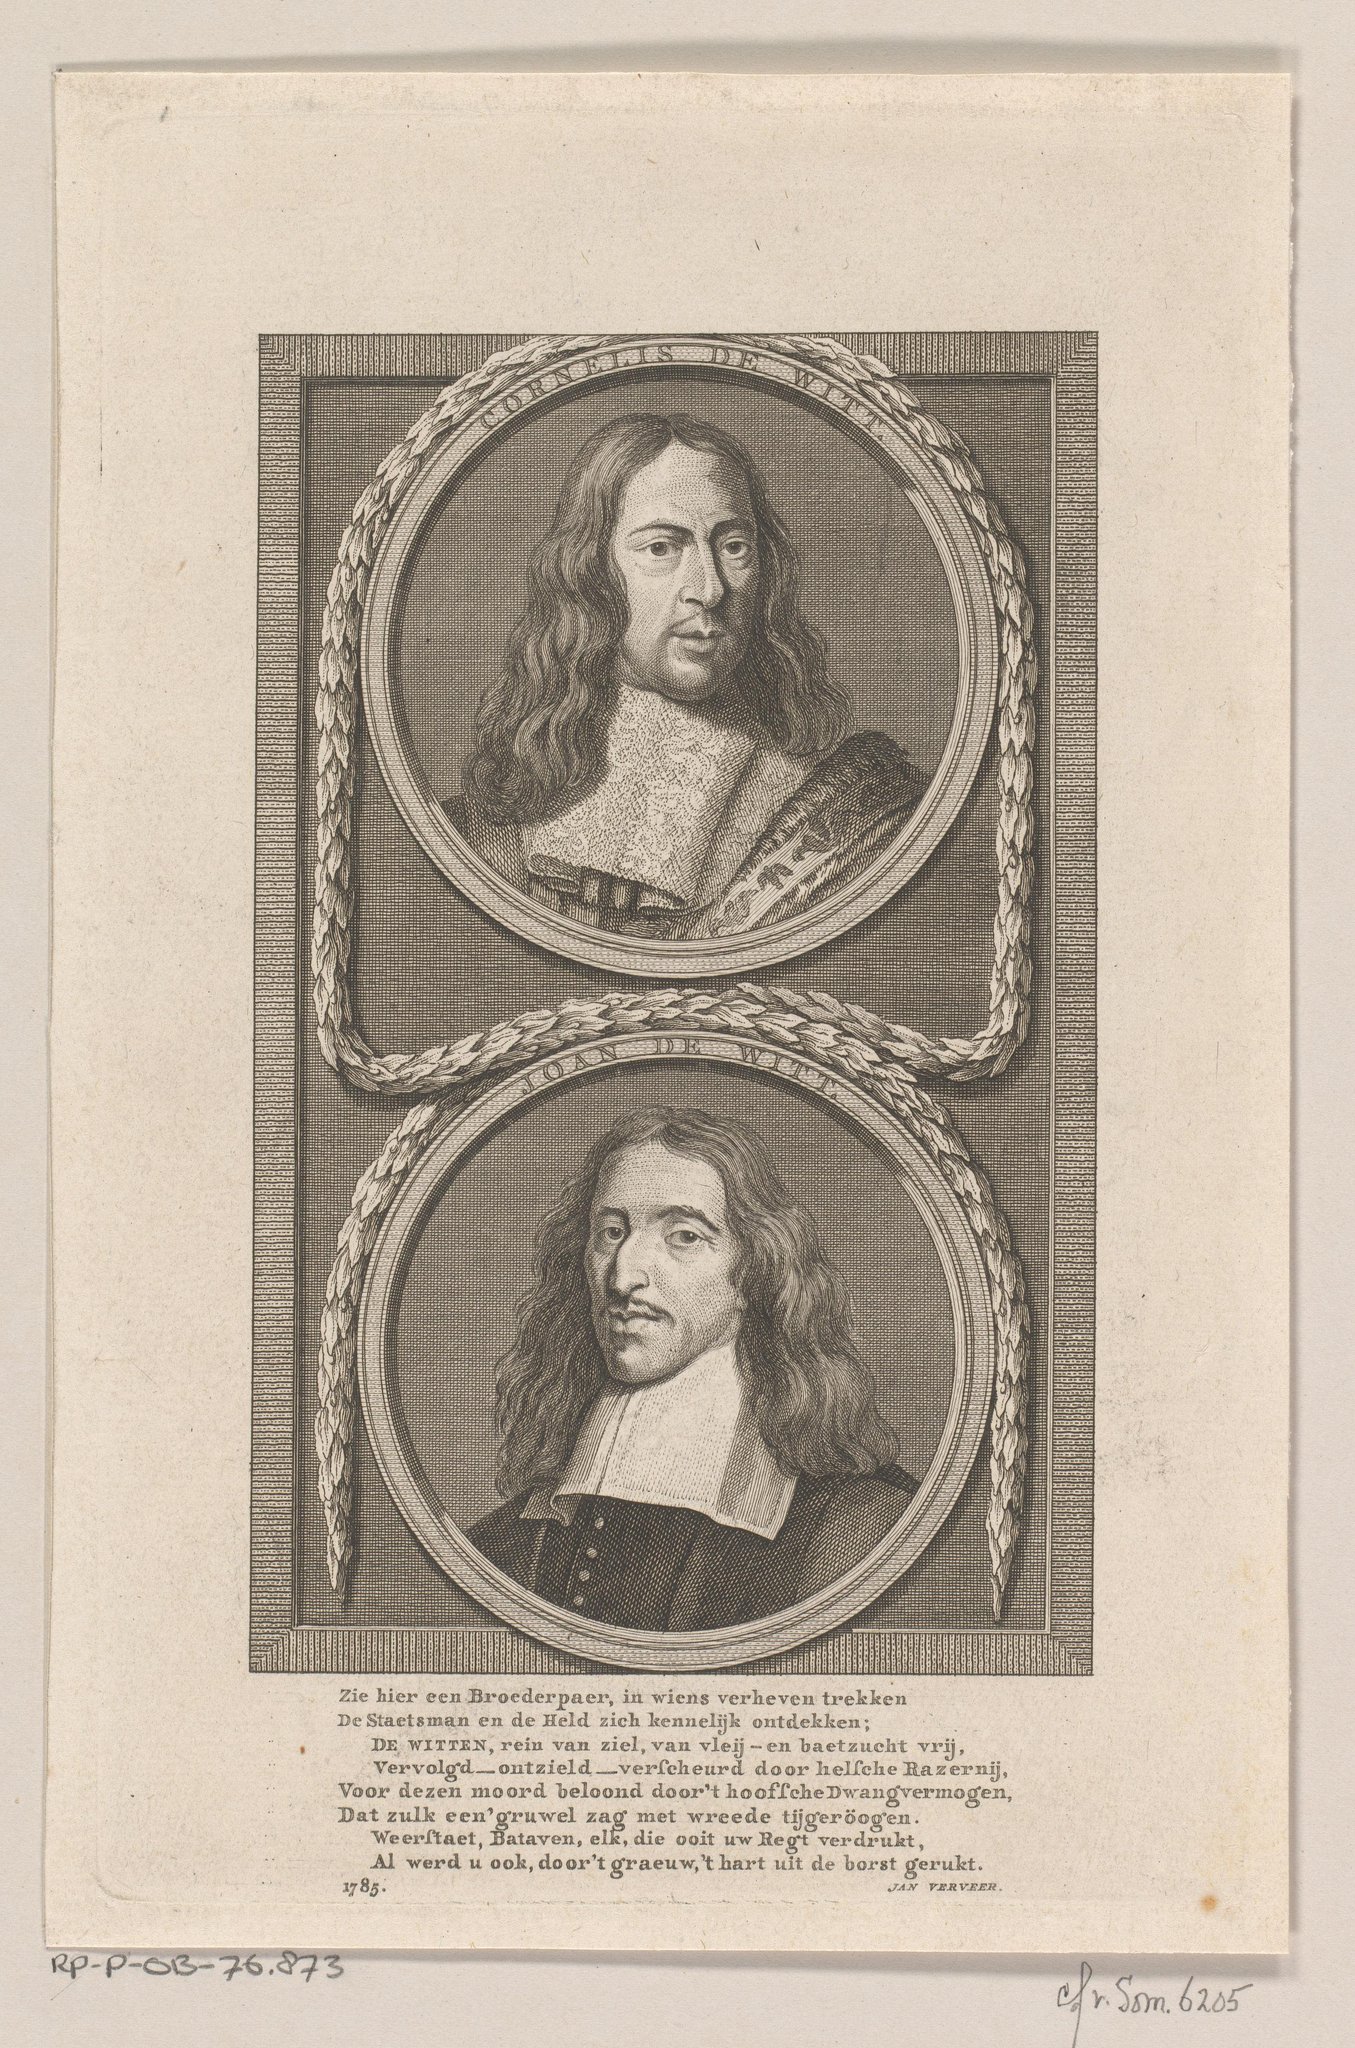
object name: print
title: Portret van Jan en Cornelis de Wit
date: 1785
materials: paper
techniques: engraving, etching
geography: low countries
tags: dordrecht, the hague, cornelis de witt, amsterdam, france, historical persons, historical events and situations